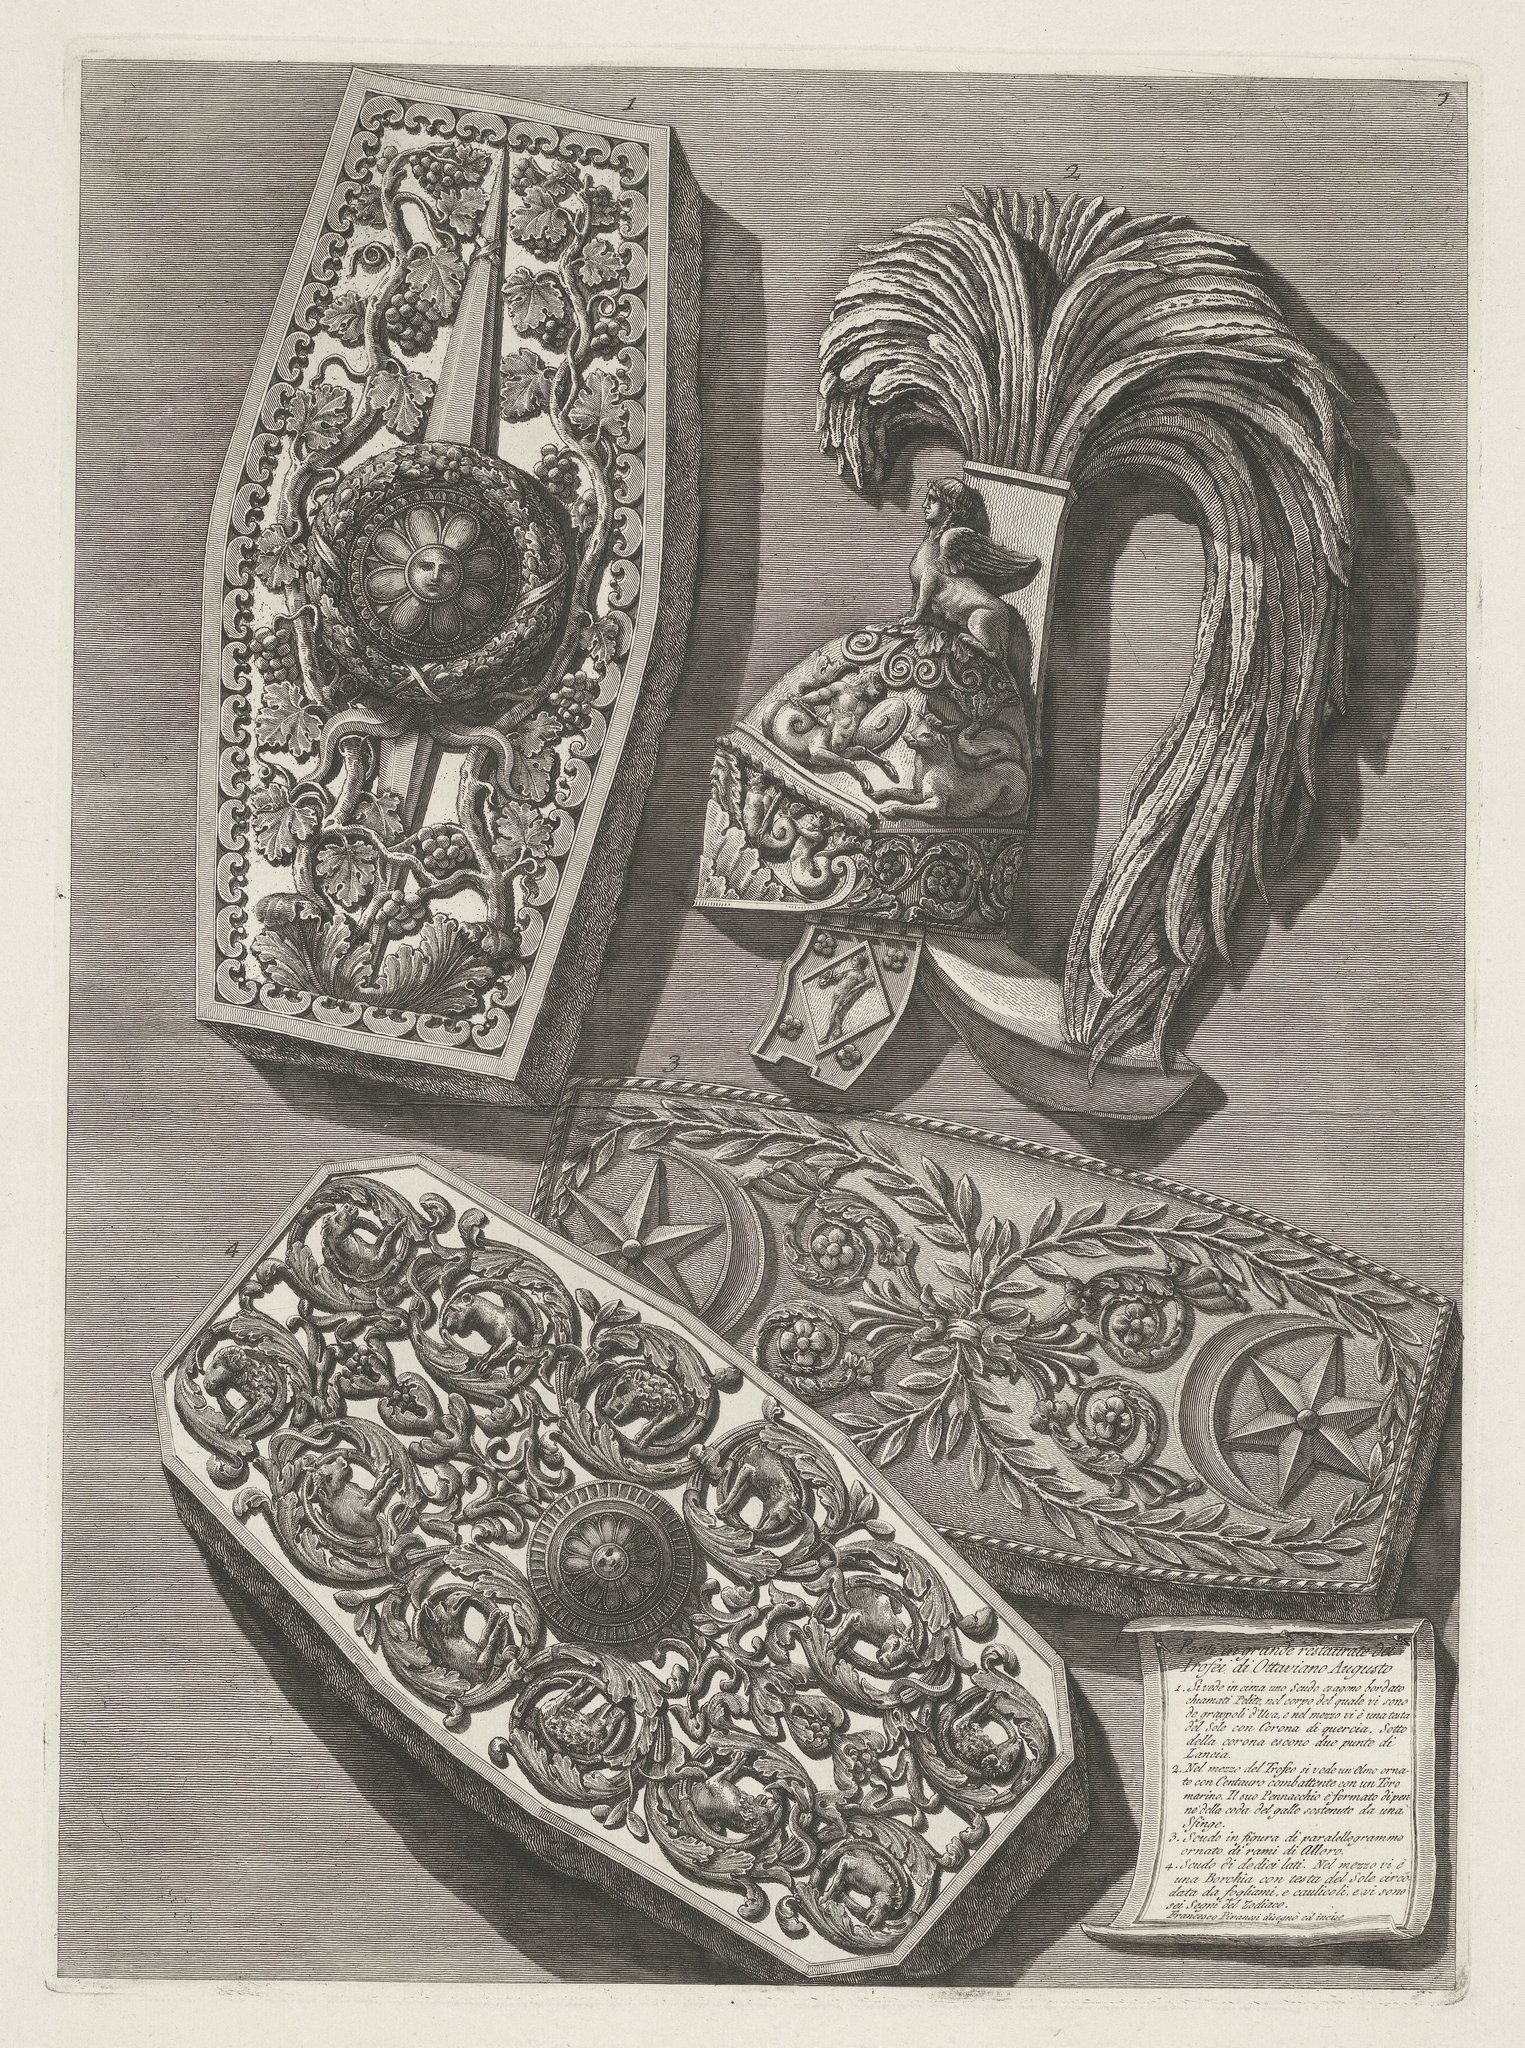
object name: print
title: Trofei di Ottaviano Augusto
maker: francesco piranesi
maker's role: print maker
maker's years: 1758-1810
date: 1753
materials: paper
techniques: etching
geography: rome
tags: piece of sculpture, reproduction of a piece of sculpture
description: Delen van een trofee van Octavianus Augustus. Drie gebeeldhouwde schilden en een helm. Rechtsonder een blad met titel en een verklarende lijst met nummers.